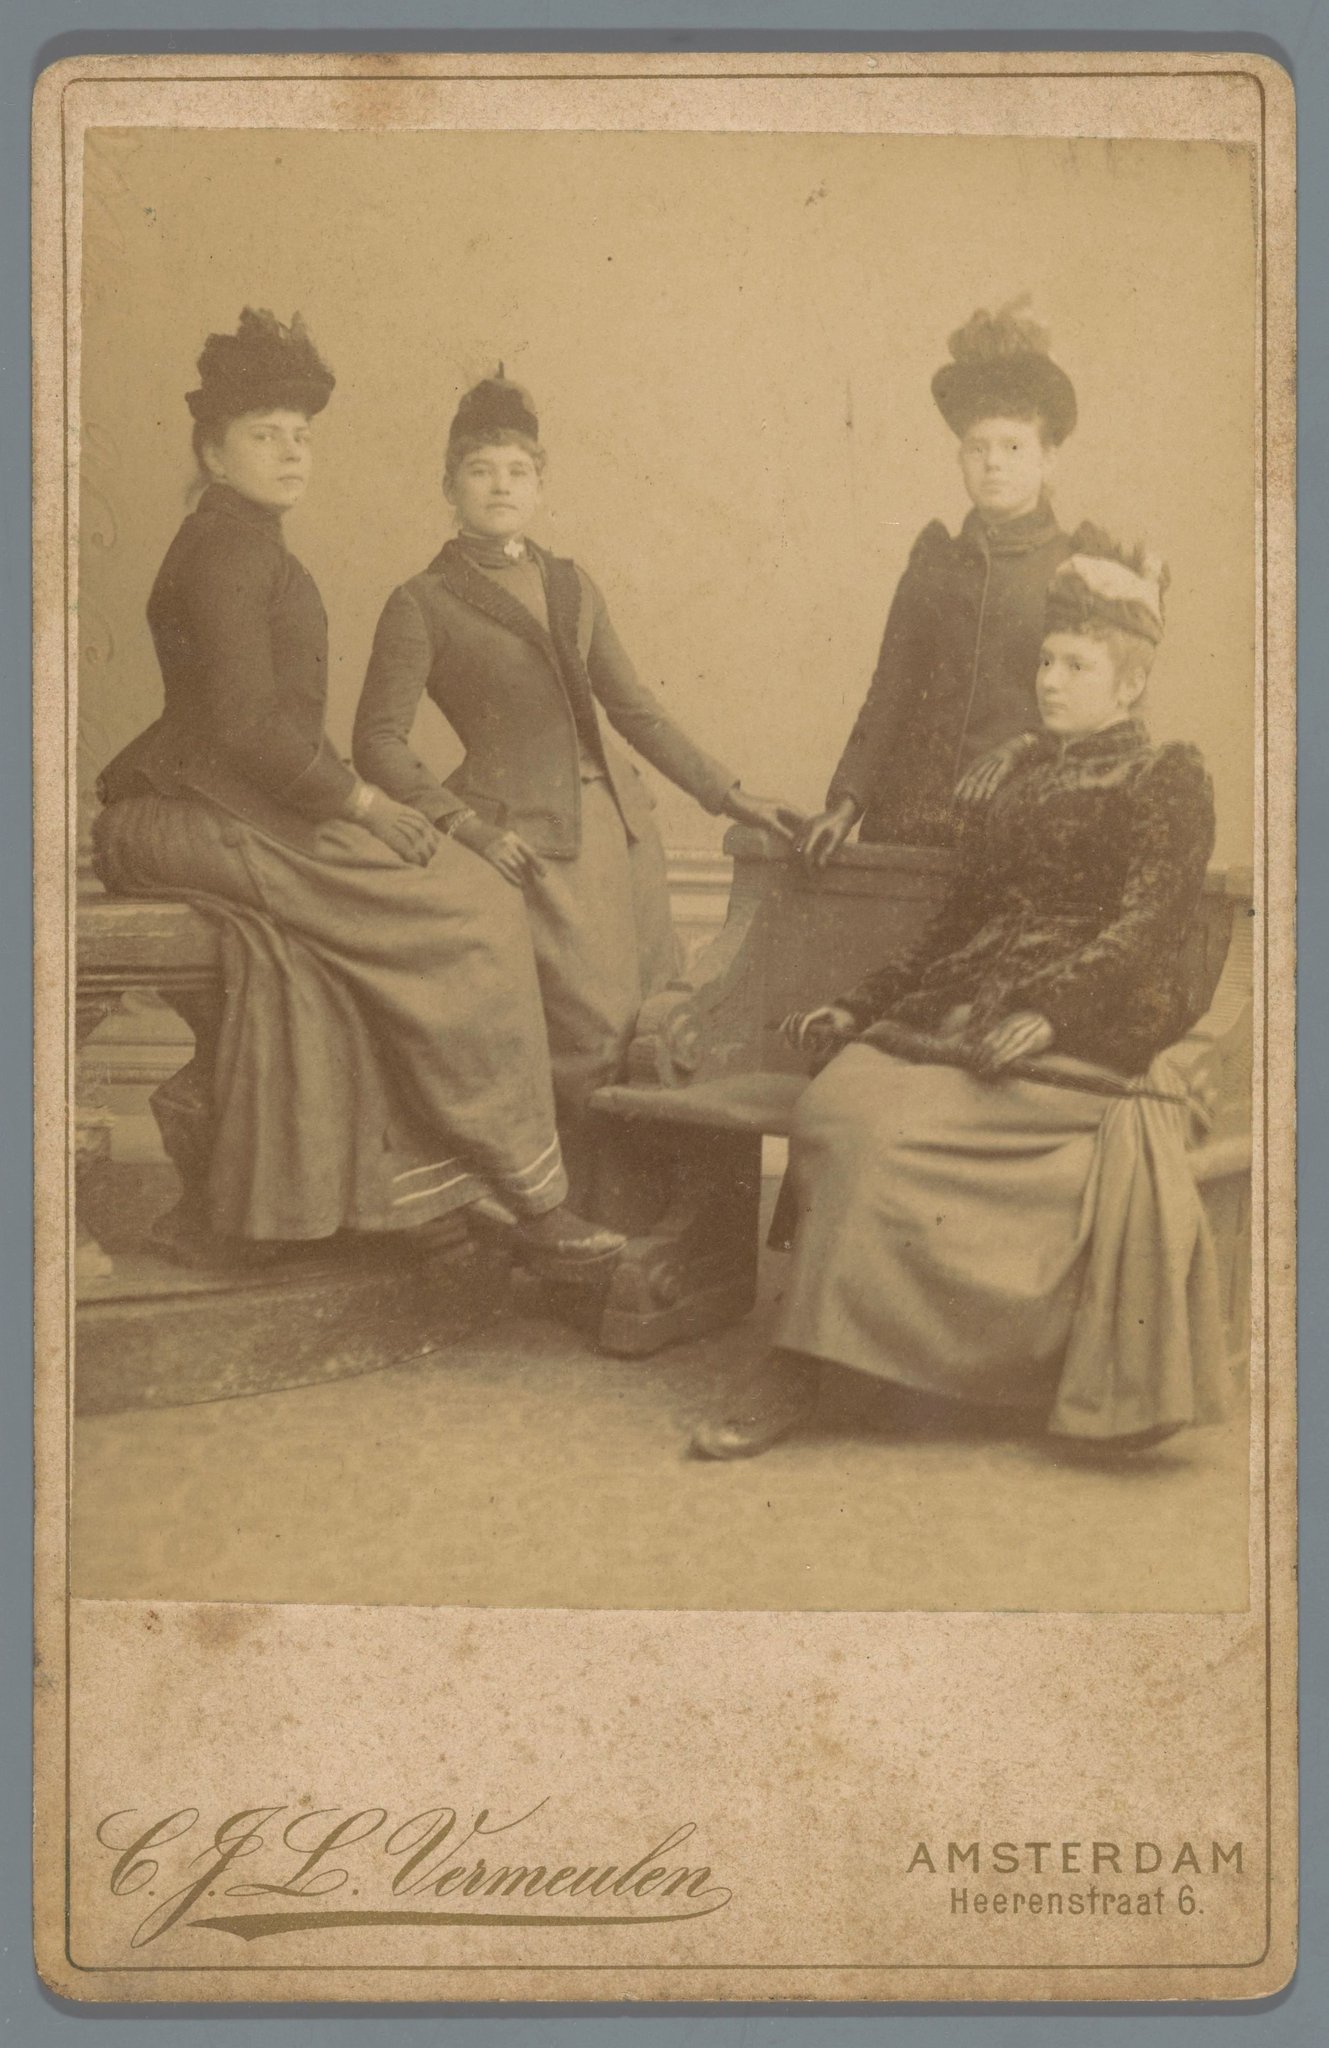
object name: cabinet photograph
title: Groepsportret van vier onbekende vrouwen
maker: cornelis johannes lodewicus vermeulen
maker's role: fotograaf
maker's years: 1861-1936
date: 1890-1910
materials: cardboard, photographic support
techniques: gelatin silver print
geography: amsterdam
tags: adult woman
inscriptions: inscription: ‘Geopend by elke weersgesteldheid (...) lage prijzen.’